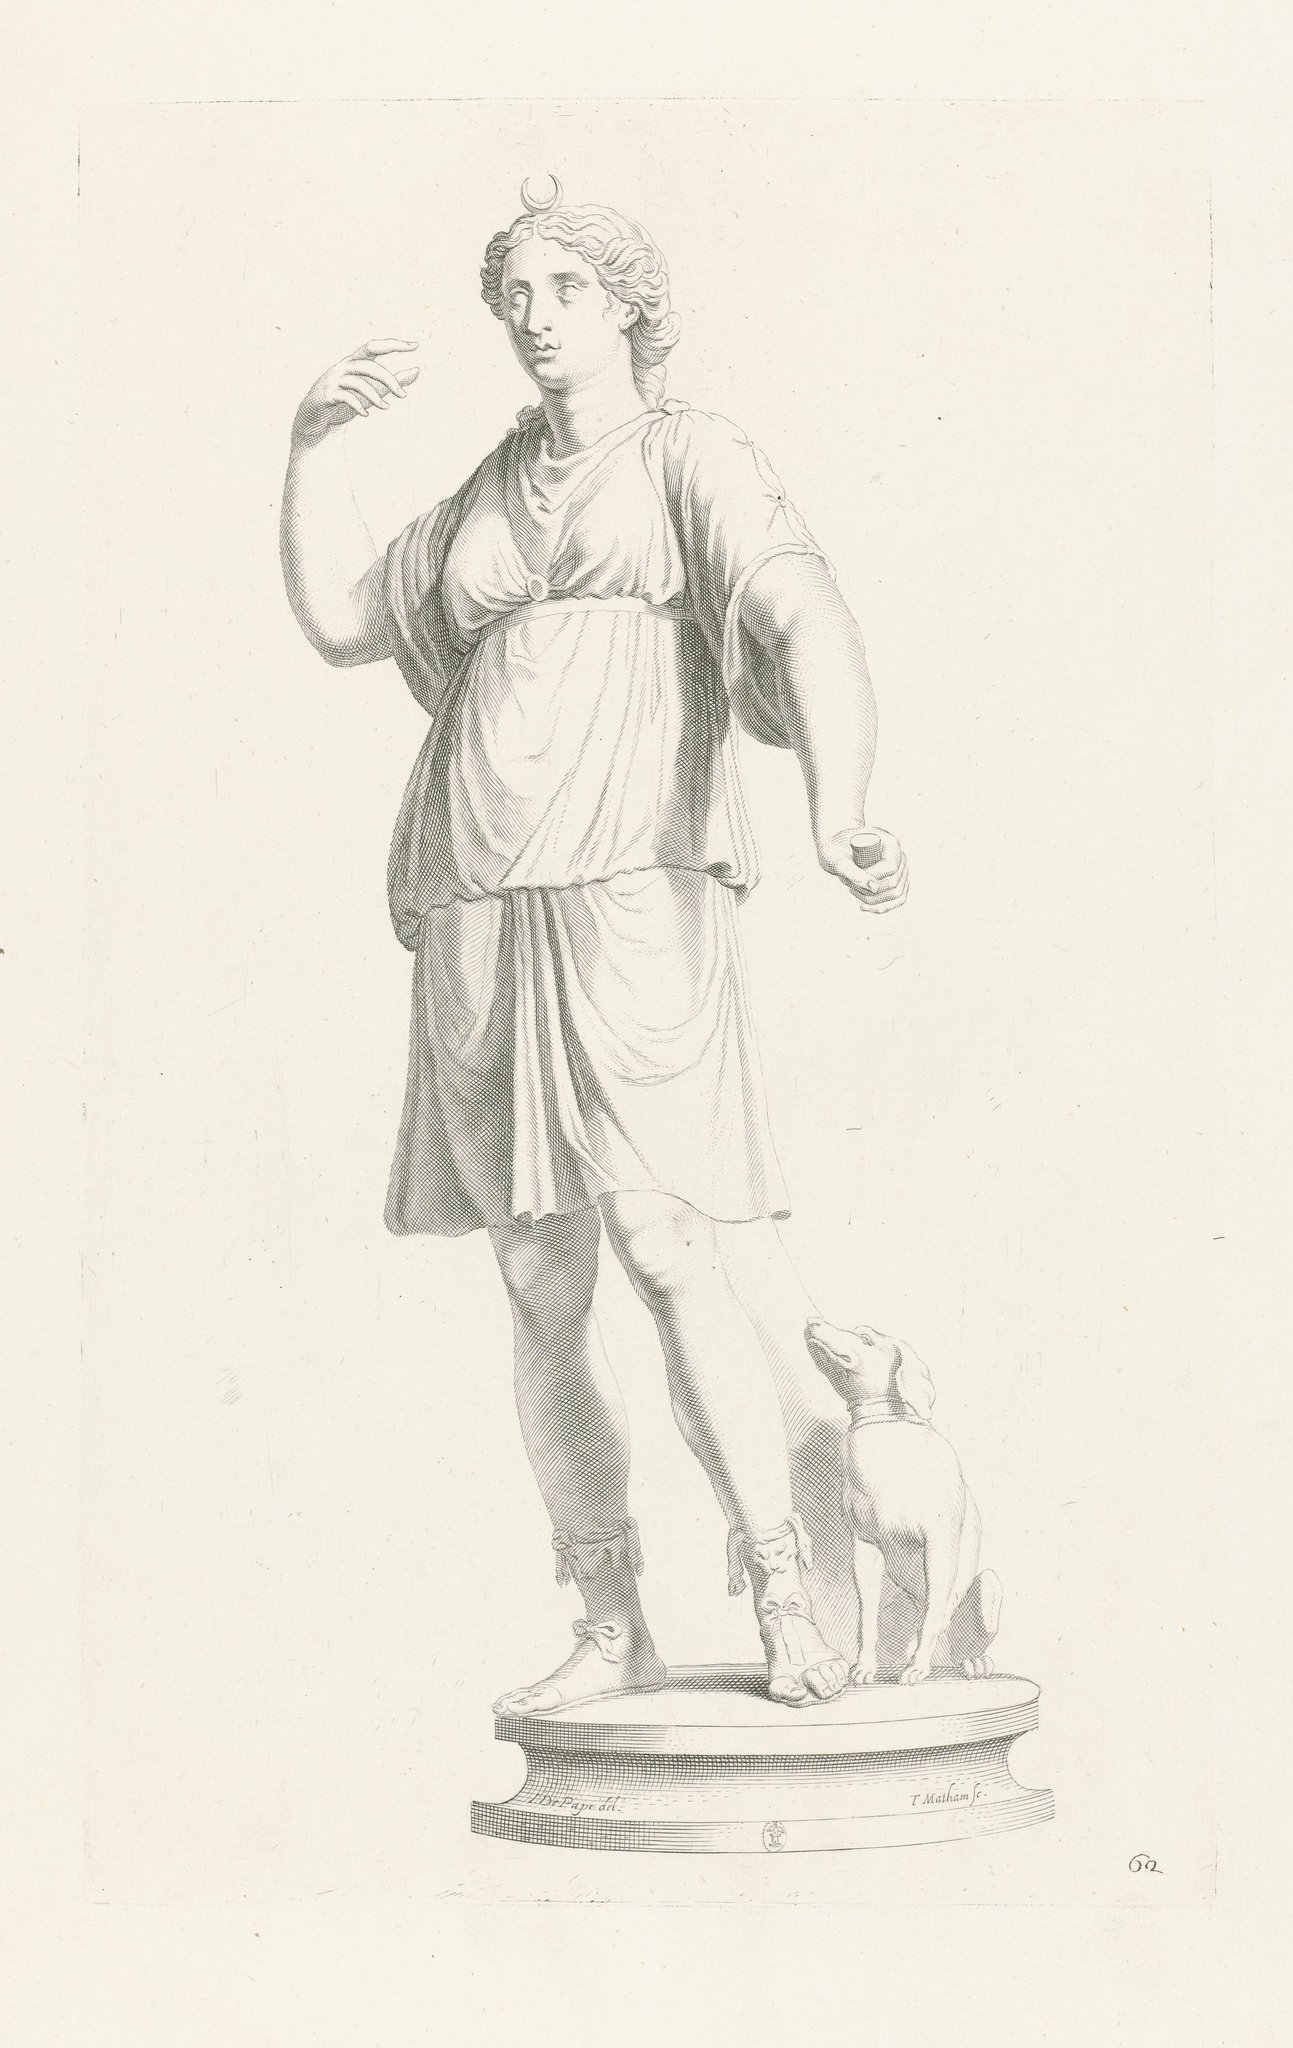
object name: print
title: Galleria Giustiniana del Marchese Vincenzo Giustiniani I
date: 1640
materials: paper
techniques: engraving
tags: rome, vincenzo giustiniani (1564-1637), (story of) diana (artemis), piece of sculpture, reproduction of a piece of sculpture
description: Standbeeld van Diana. Op de sokkel het wapenschild van Vincenzo Giustiniani. Prent uit een publicatie met reproductieprenten naar de sculpturen in de verzameling in de Galleria Giustiniani te Rome.